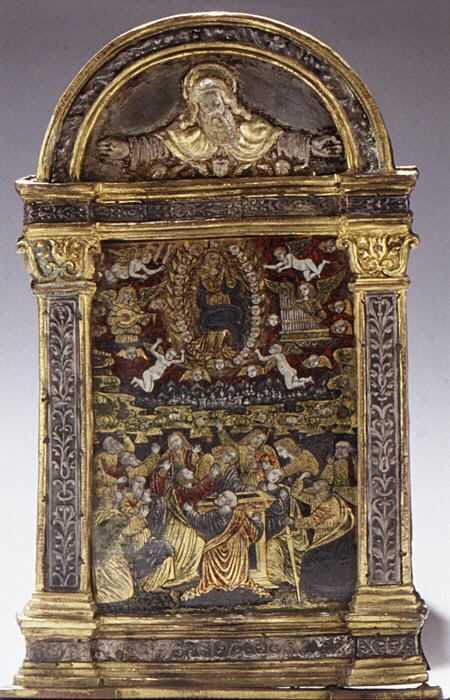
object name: pax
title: Assumption of the Virgin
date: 1501-1600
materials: gilt, silver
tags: assumption of the virgin,god the father